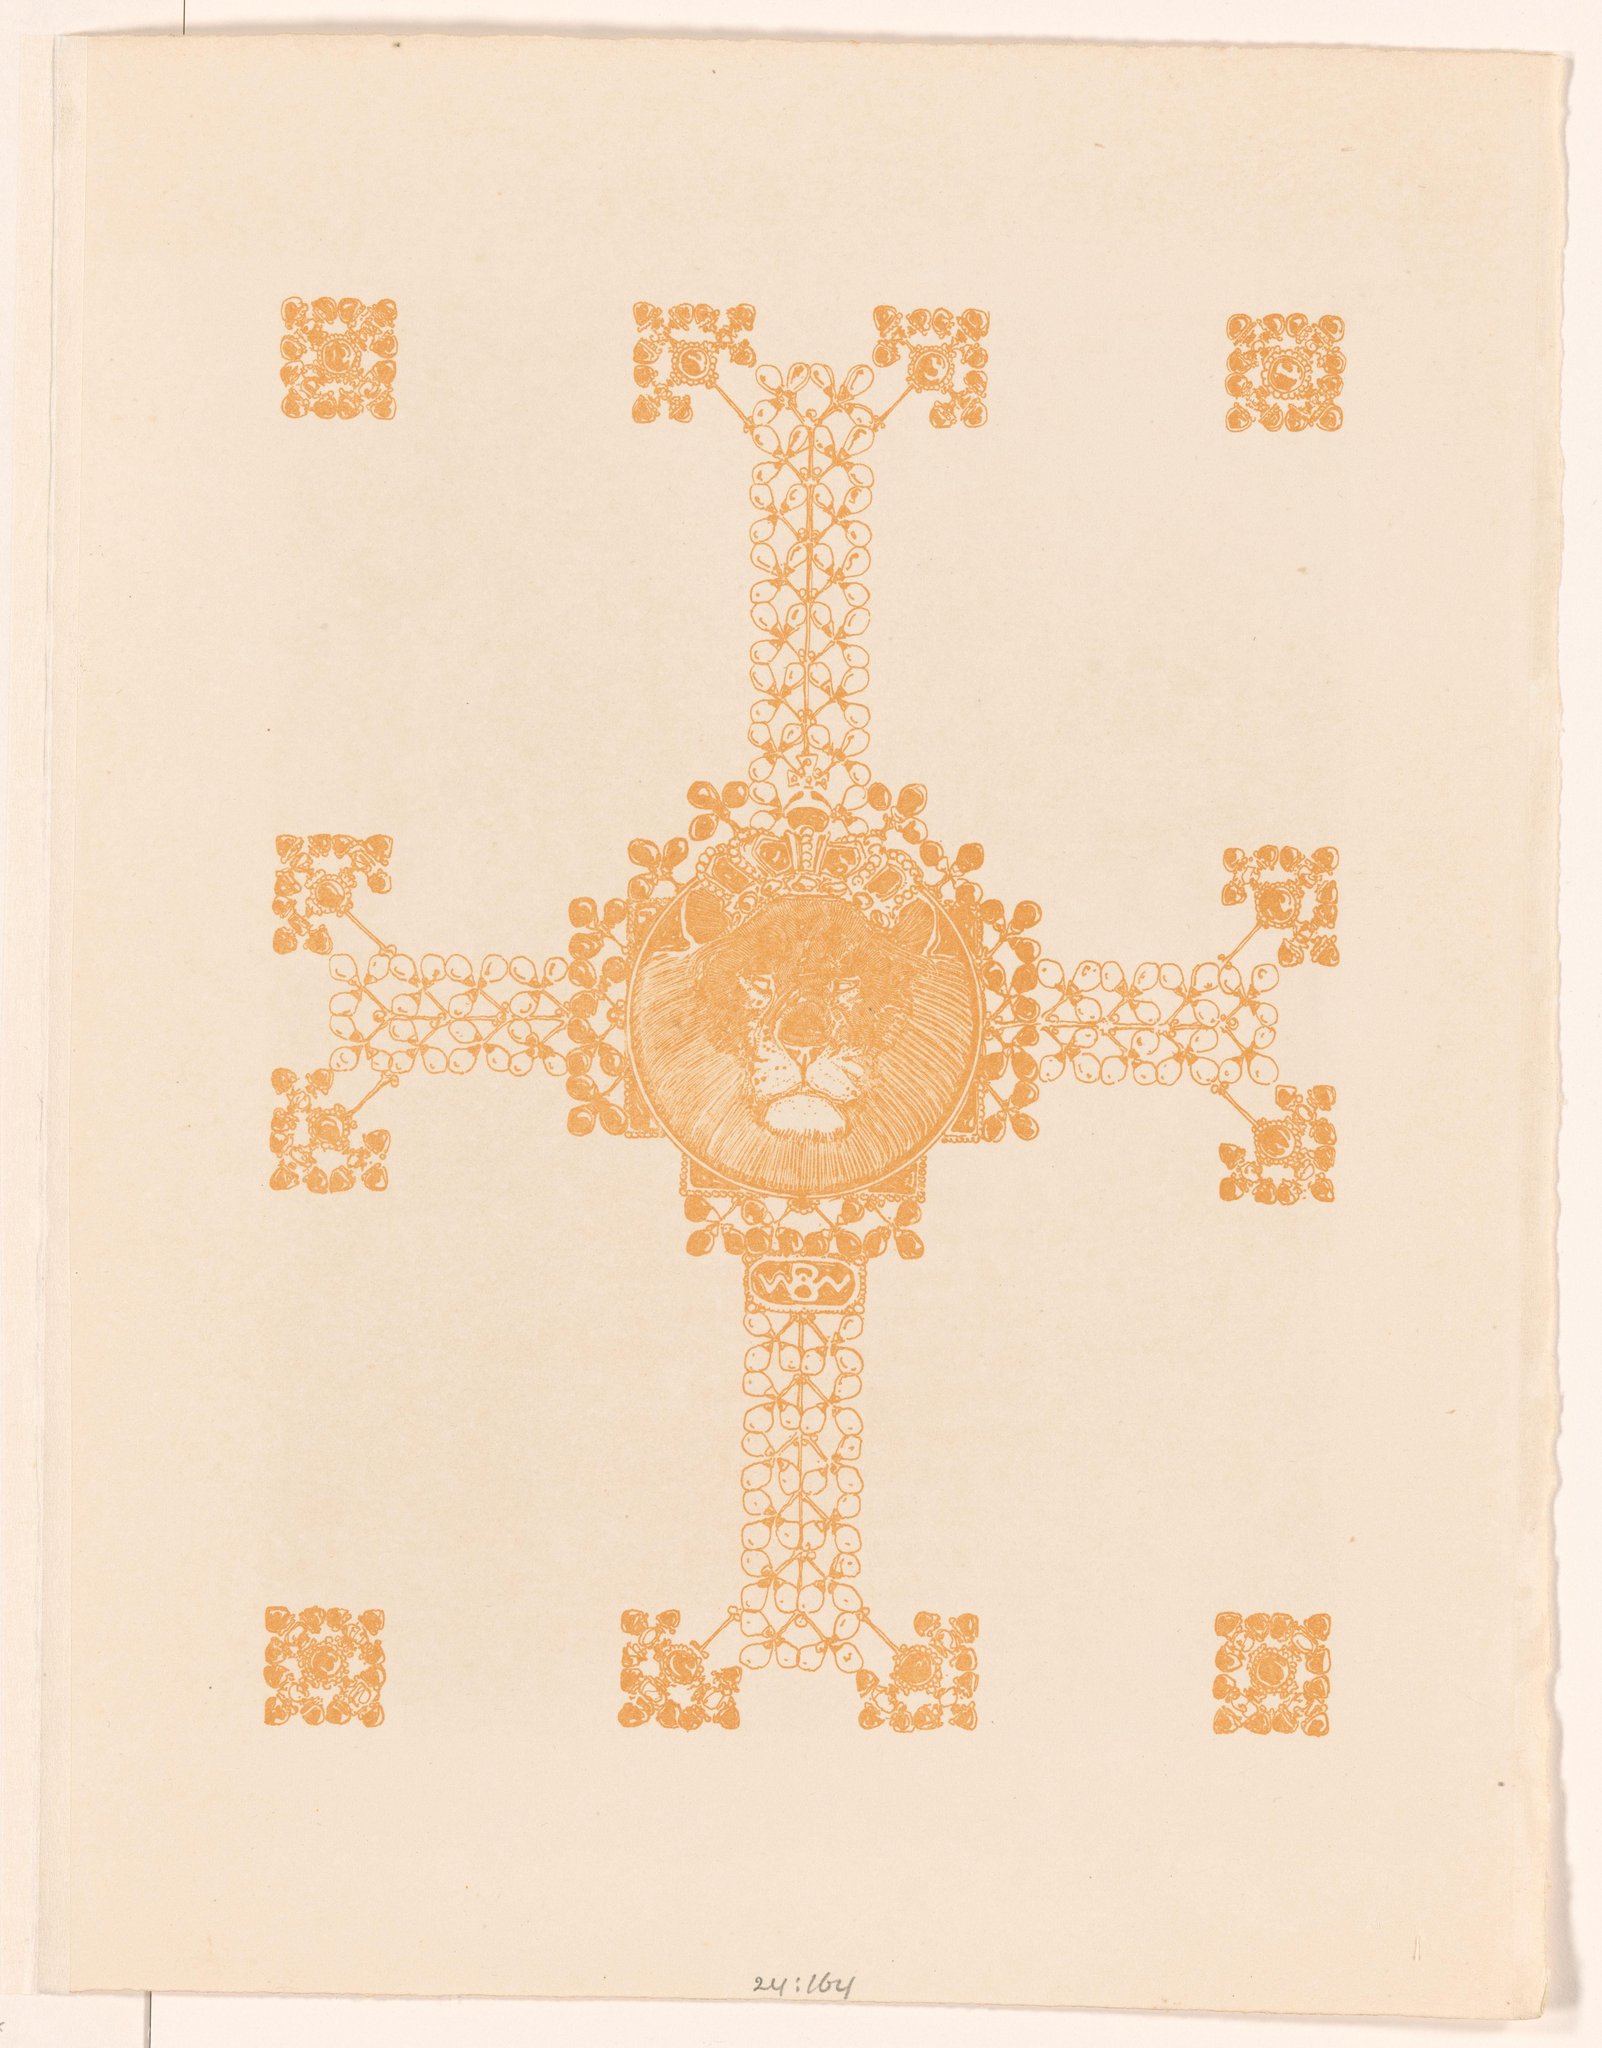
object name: print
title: Ornamentiek en gekroonde leeuw (Nobel)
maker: bernard willem wierink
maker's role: draughtsman, print maker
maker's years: 1856-1939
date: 1910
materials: paper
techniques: lithograph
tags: fable of reynard the fox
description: Prent gebruikt in: Streuvels, Stijn (Frank Lateur). Reinaert de Vos naar verschillende uitgaven van het middeleeuwsche epos. Amsterdam: L.J. Veen, 1910.